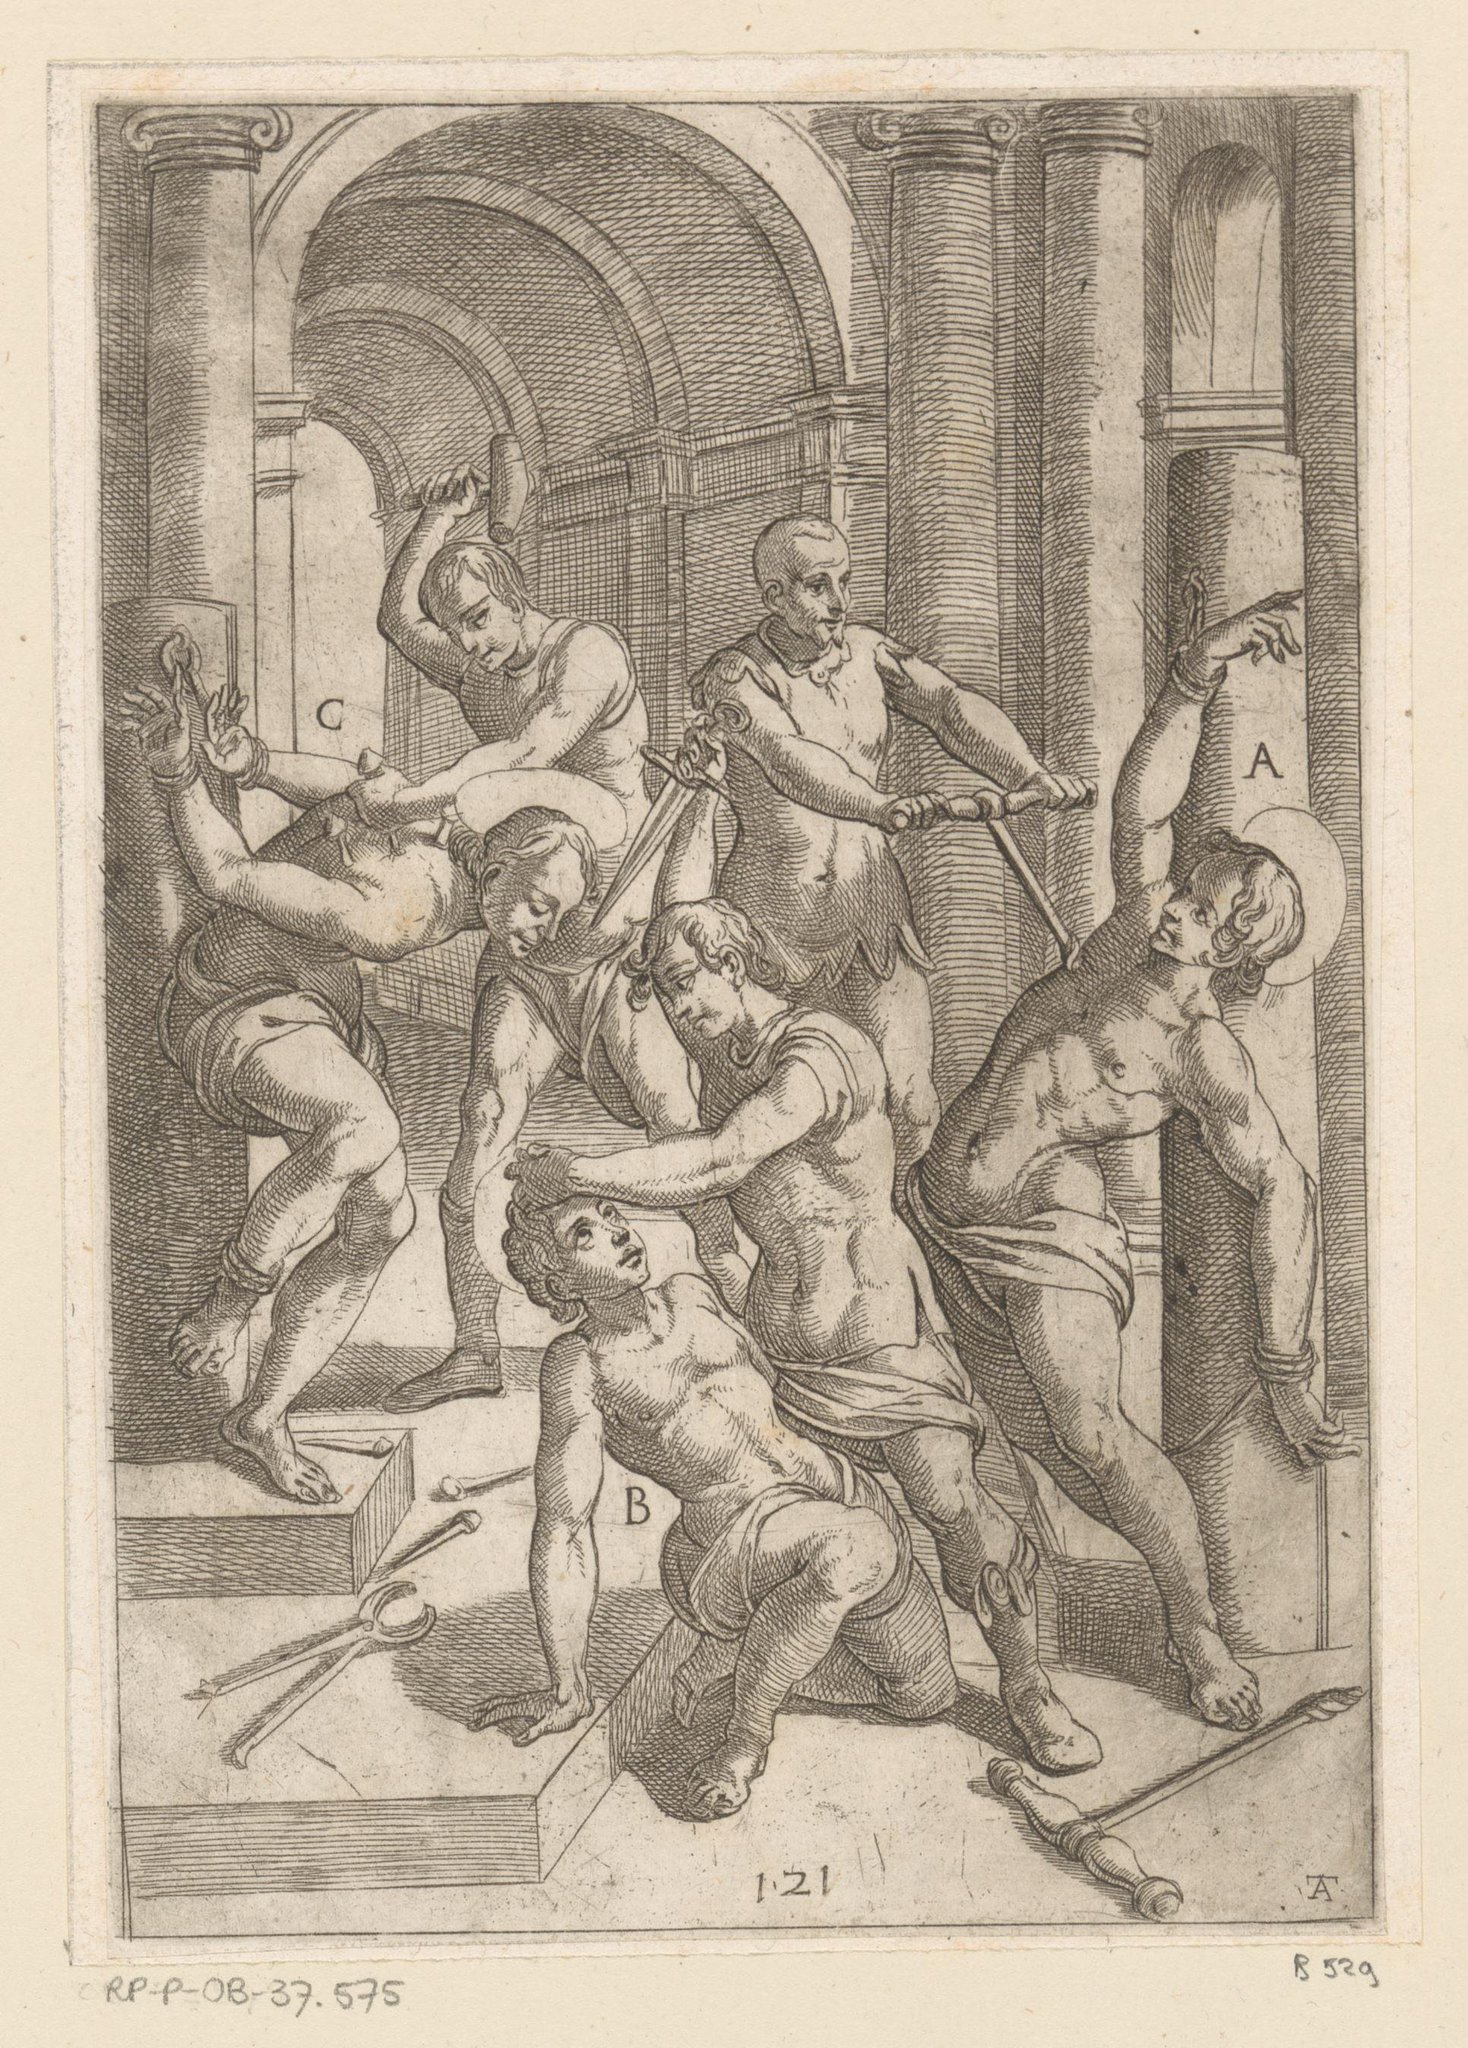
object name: print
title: Varia tormentorum et supplicioru crudelium (...)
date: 1565-1630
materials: paper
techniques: etching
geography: rome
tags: violent death ~ maltreatment, torture, torture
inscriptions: collector's mark: Lugt 240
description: Deze prent maakt deel uit van een reeks van 47 prenten (+ titelprent) met voorstellingen van martelmethoden. Deze prenten zijn in een andere editie gebruikt als illustraties voor Antonio Gallonio's 'Trattato degli Instrumenti di Martirio e delle Varie Maniere di Martoriare Usate dai Gentili contro Christiani' (Rome, Ascanio en Girolamo Dongangeli, 1591).